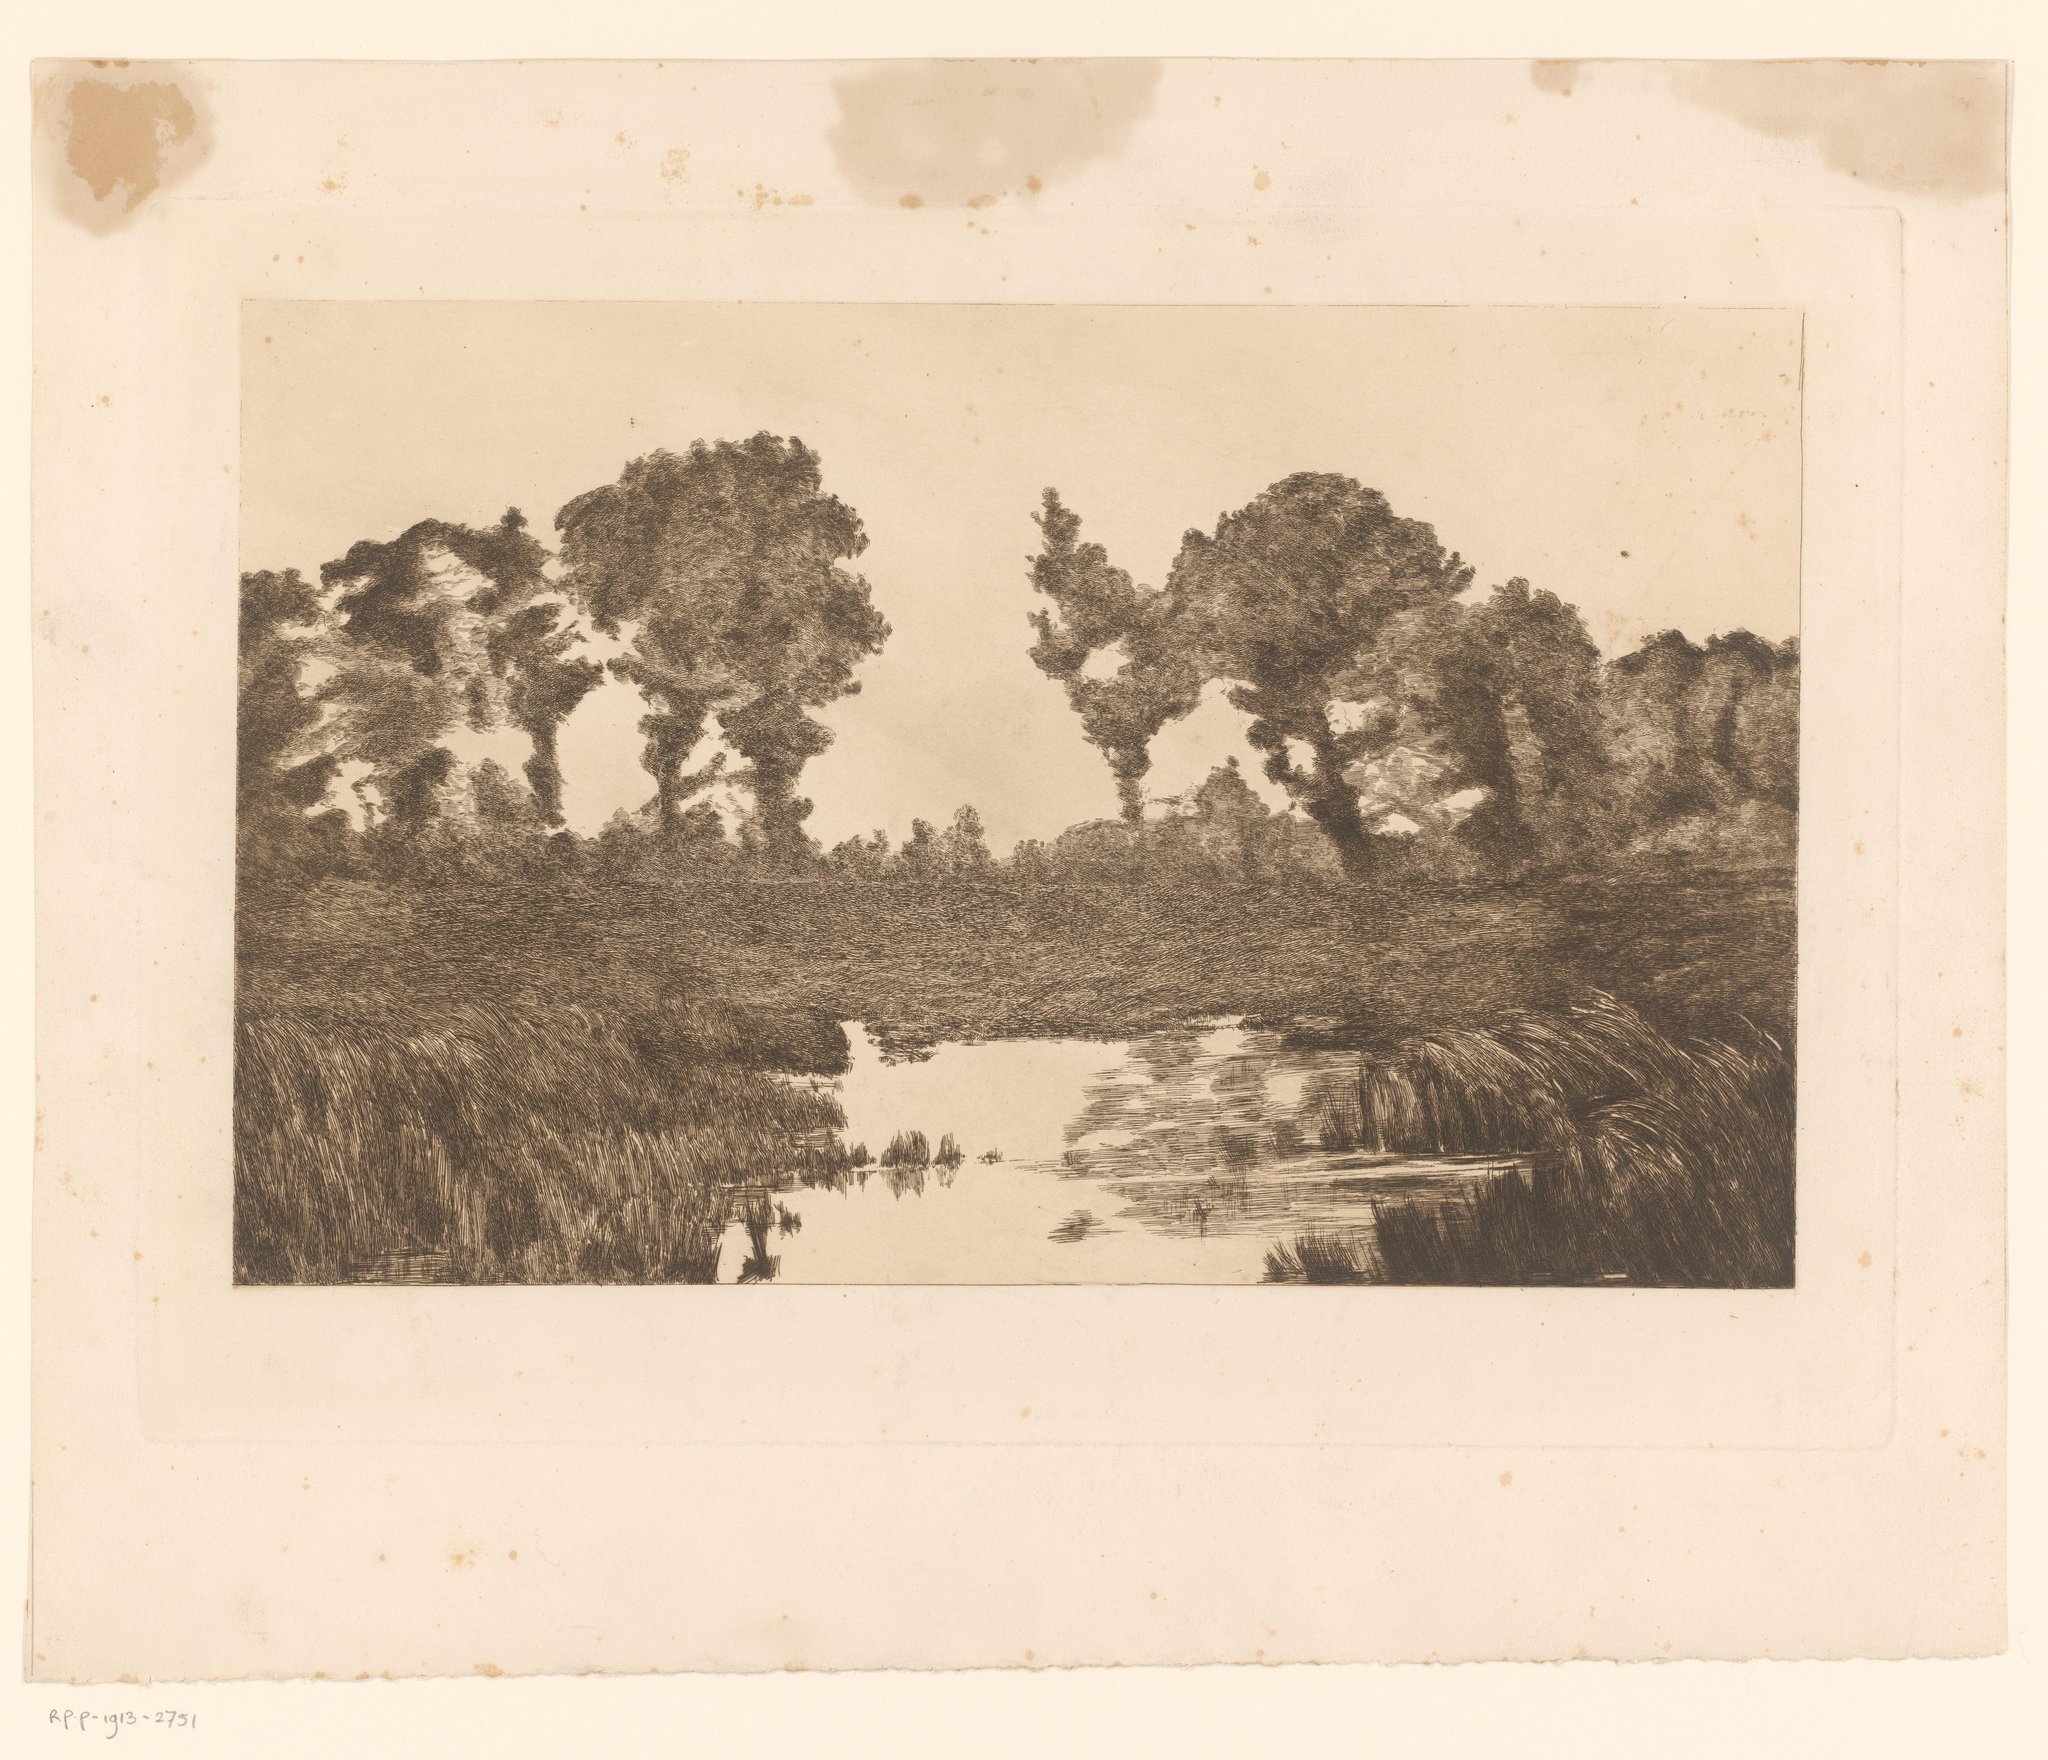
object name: print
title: Landschap met waterplas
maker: henri rul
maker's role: print maker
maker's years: 1862-1942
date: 1872-1913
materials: paper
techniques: etching, intaglio, retroussage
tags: pond, pool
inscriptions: collector's mark: Lugt 2228